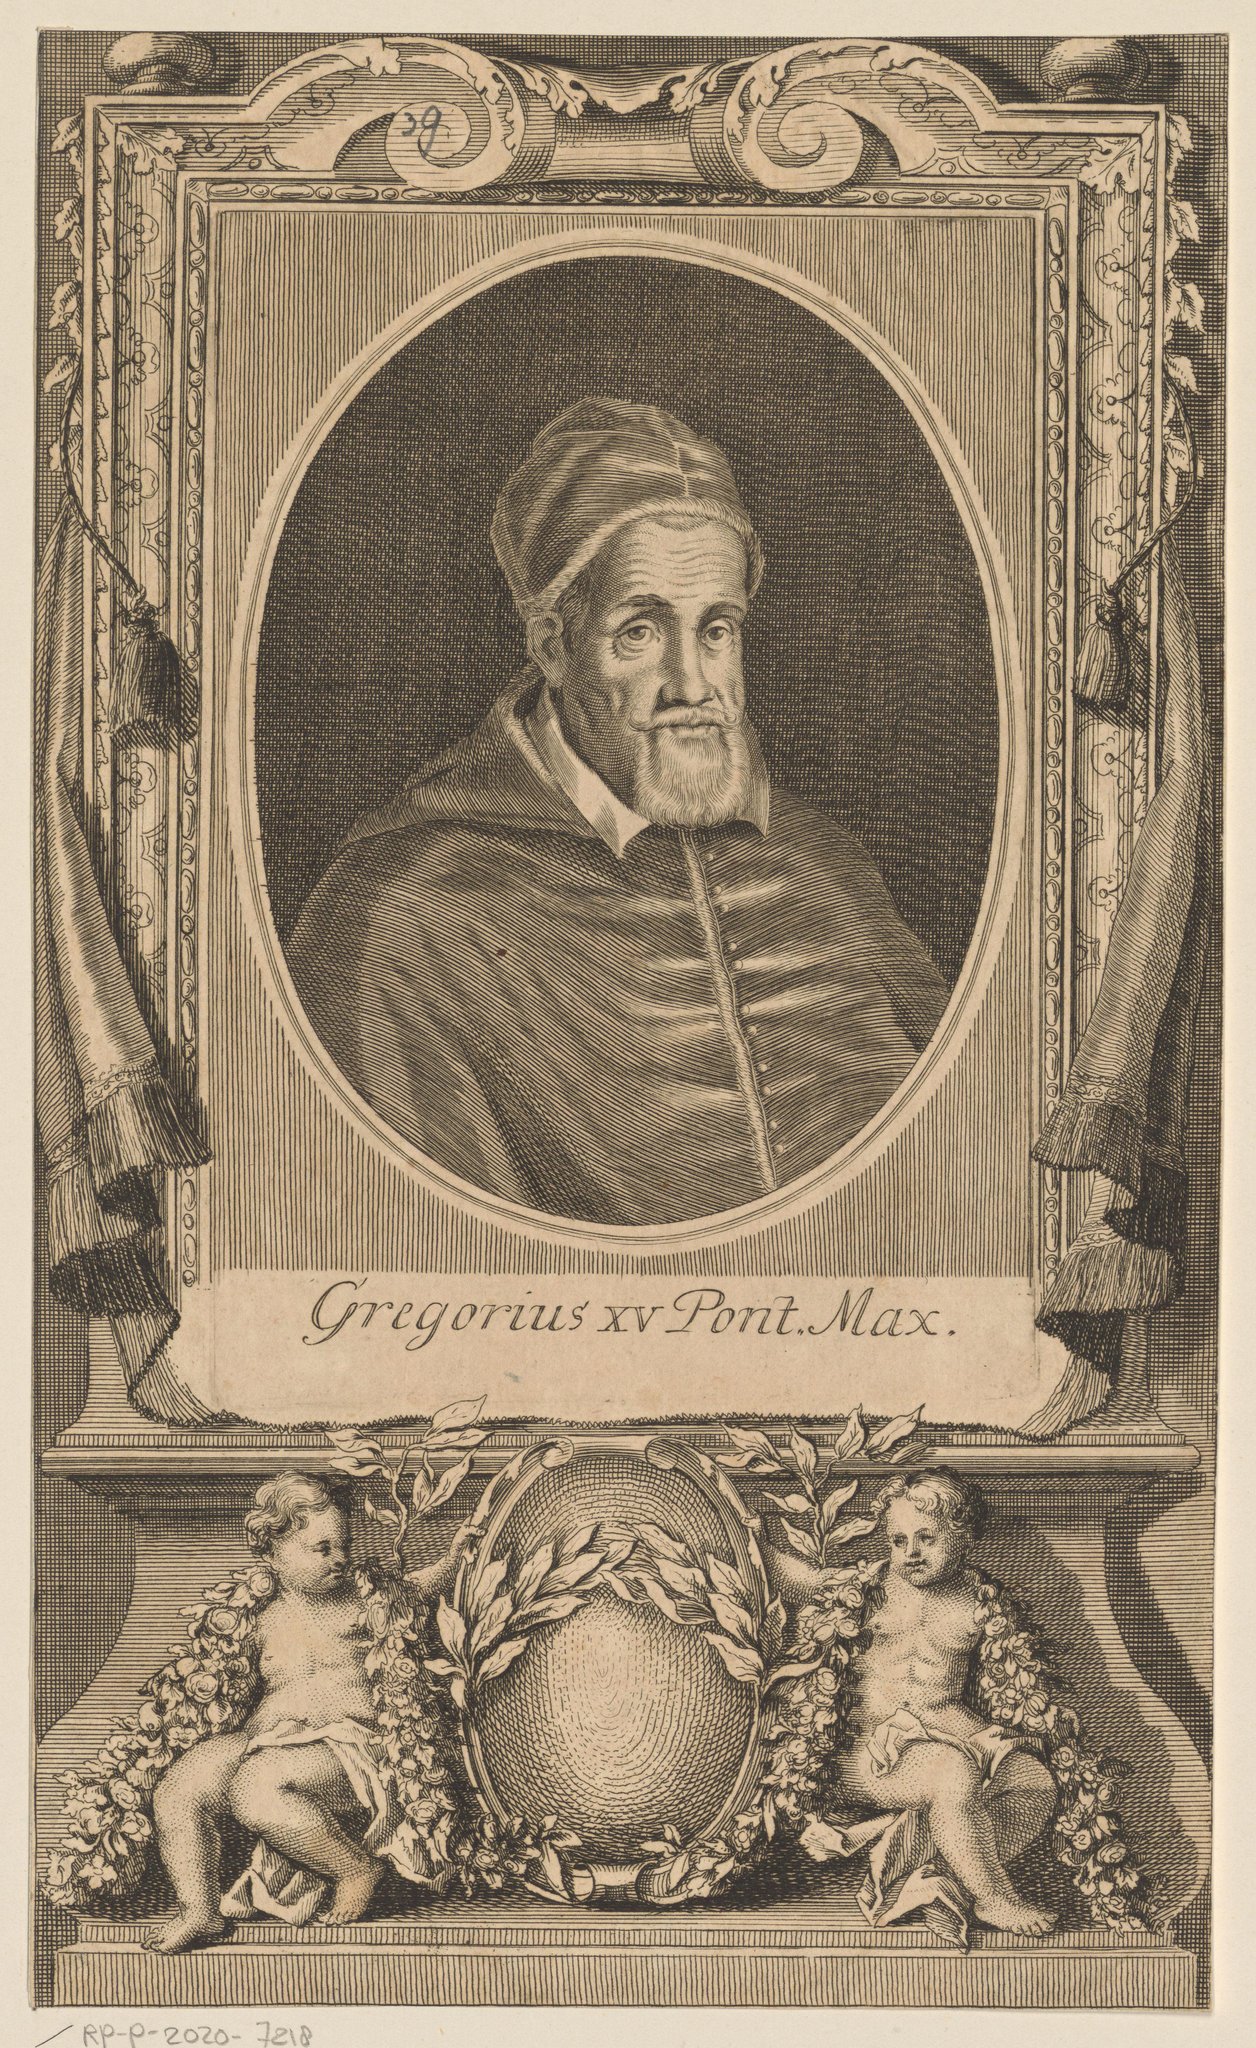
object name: print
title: Portret van paus Gregorius XV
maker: Anonymous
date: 1650-1750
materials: paper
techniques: engraving, etching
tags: rome, gregorius xv, historical persons, pope, cupids: 'amores', 'amoretti', 'putti'